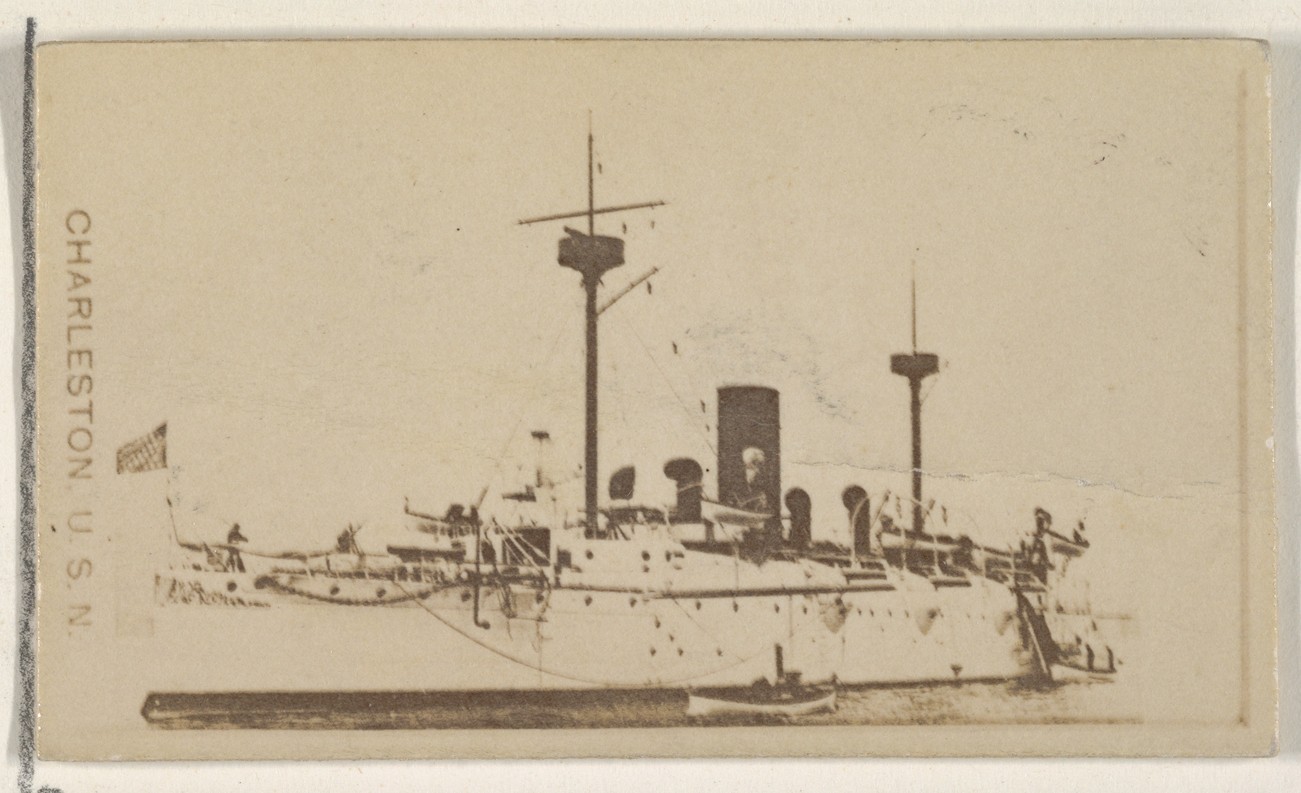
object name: photograph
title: Charleston, U.S.N., from the Famous Ships series (N50) for Virginia Brights Cigarettes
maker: allen & ginter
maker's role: publisher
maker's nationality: american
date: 1895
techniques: albumen silver print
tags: ships